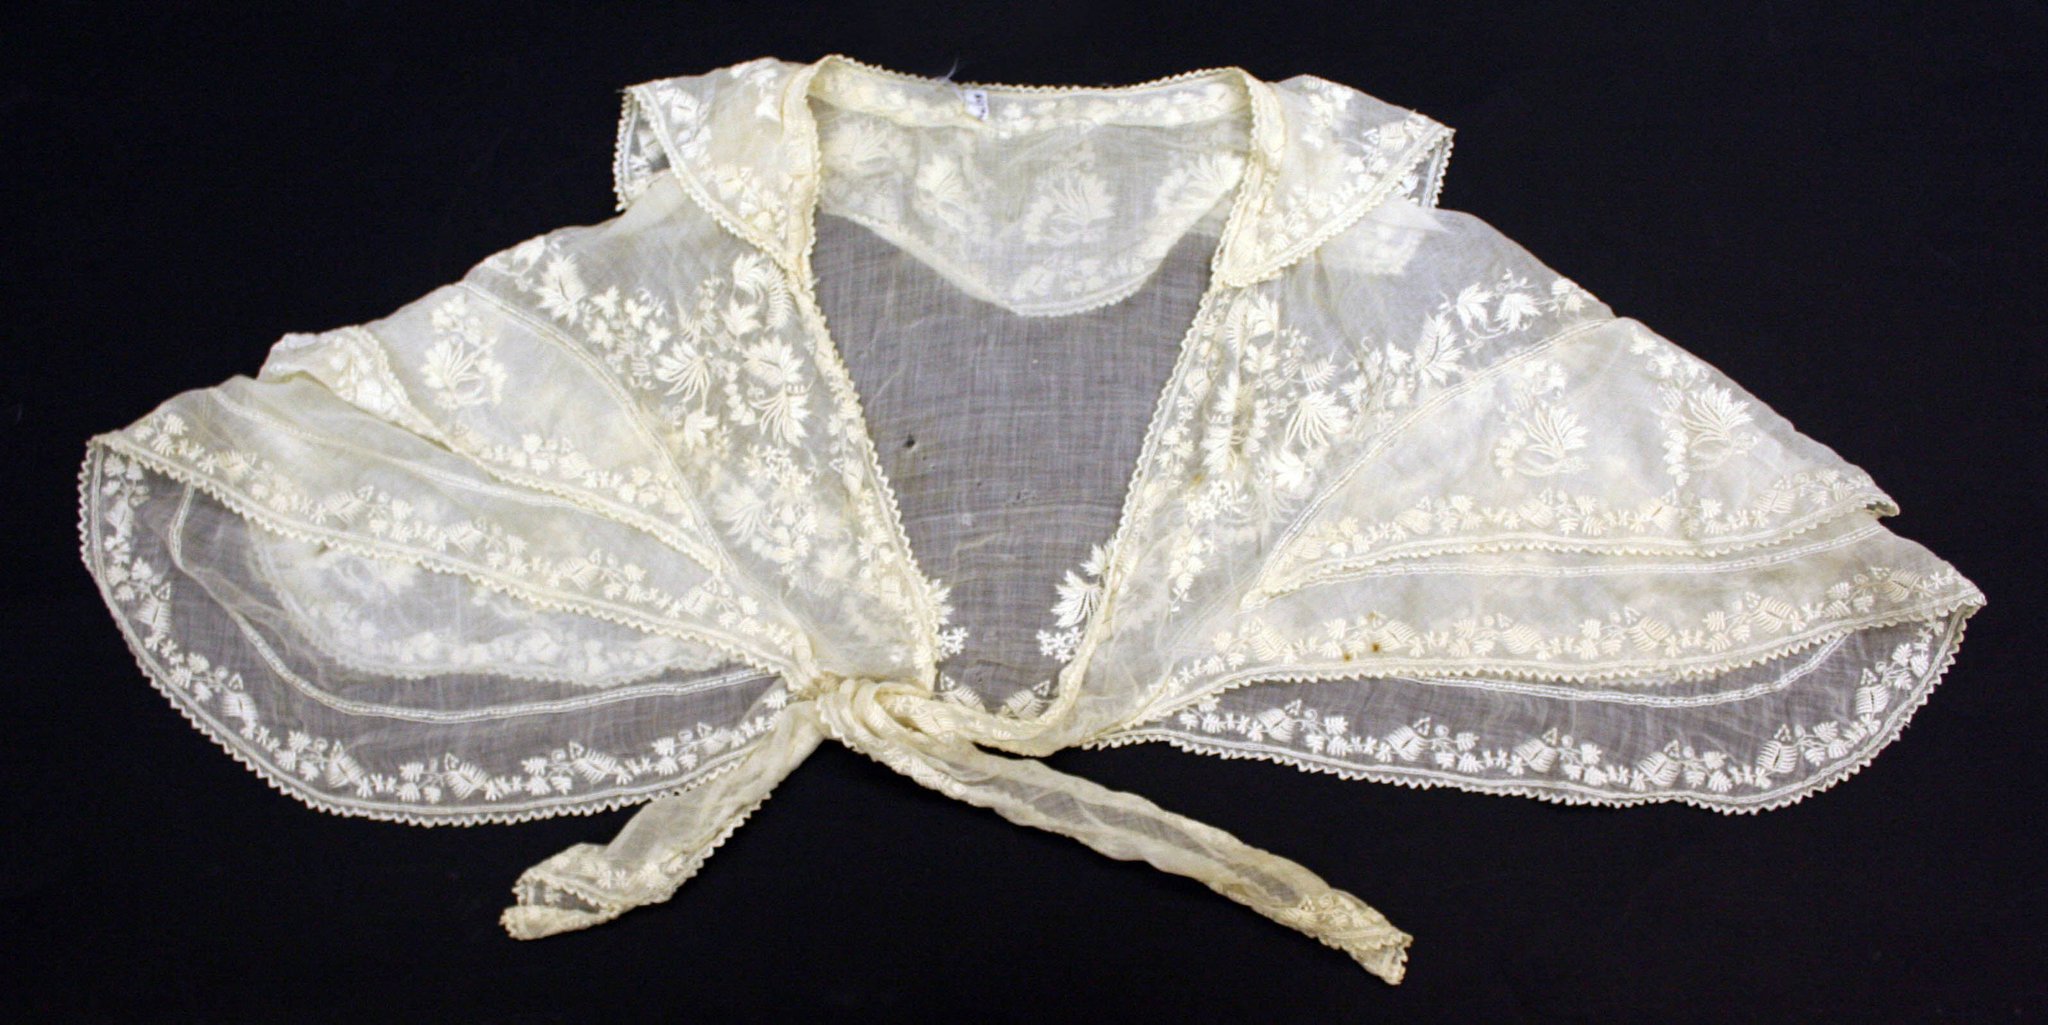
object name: pelerine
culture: american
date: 1825-1850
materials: cotton